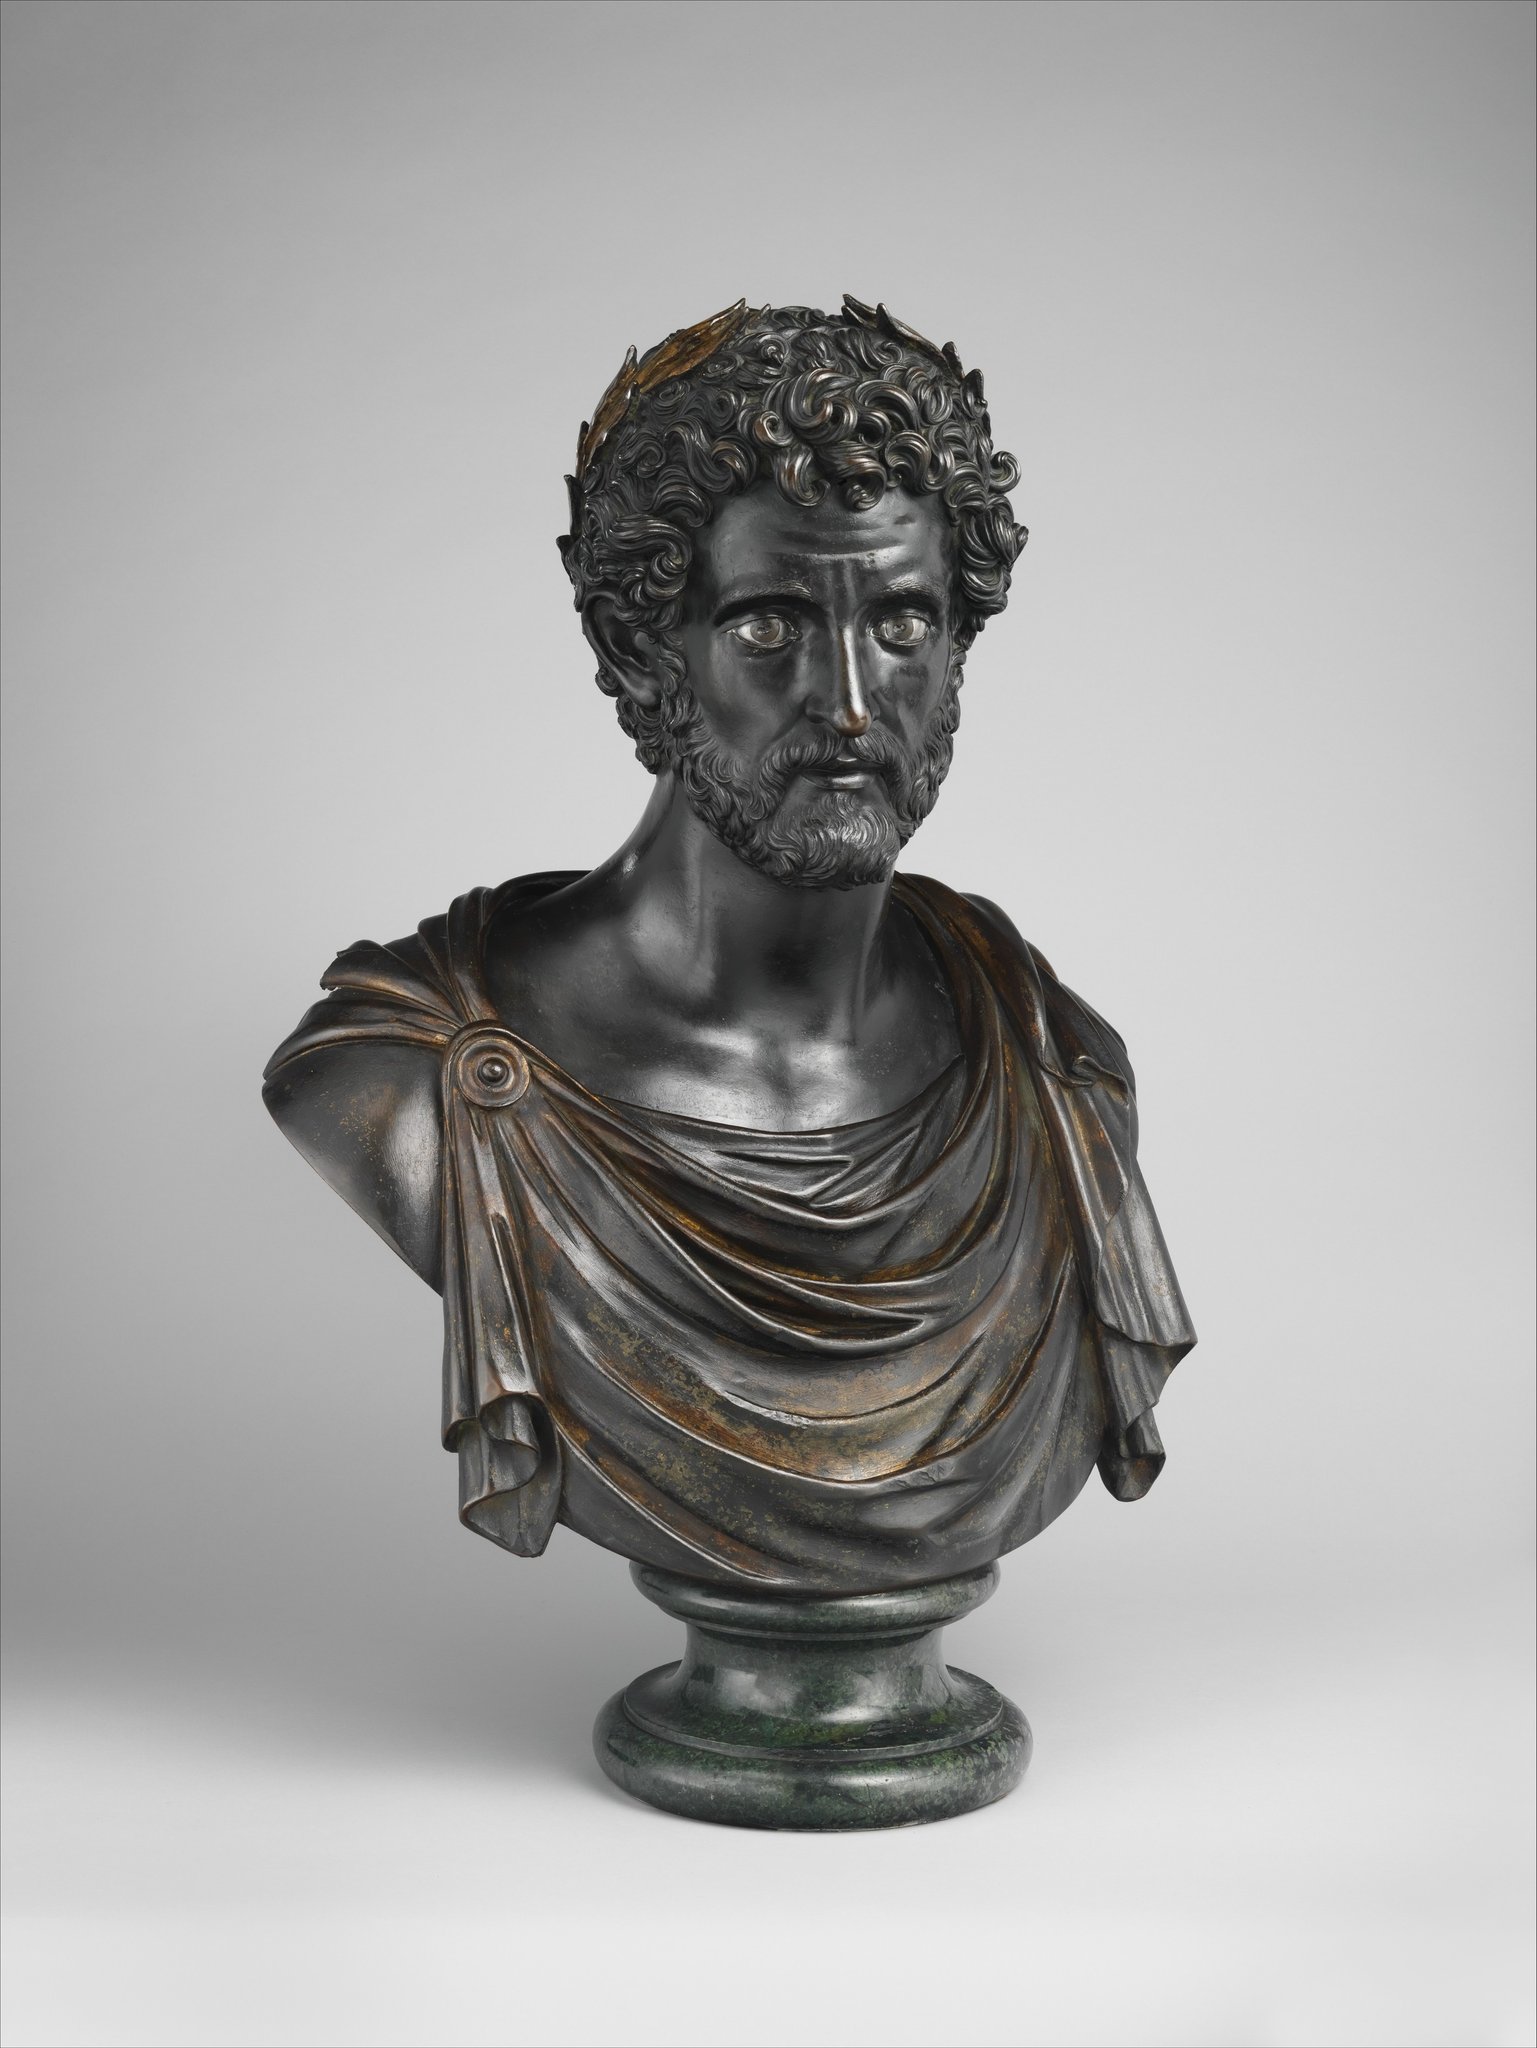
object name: bust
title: Emperor Antoninus Pius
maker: antico (pier jacopo alari bonacolsi)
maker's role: artist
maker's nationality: italian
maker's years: 1460-1528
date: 1519-1524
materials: bronze, gilt, oil, stone, silver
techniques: inlay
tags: men